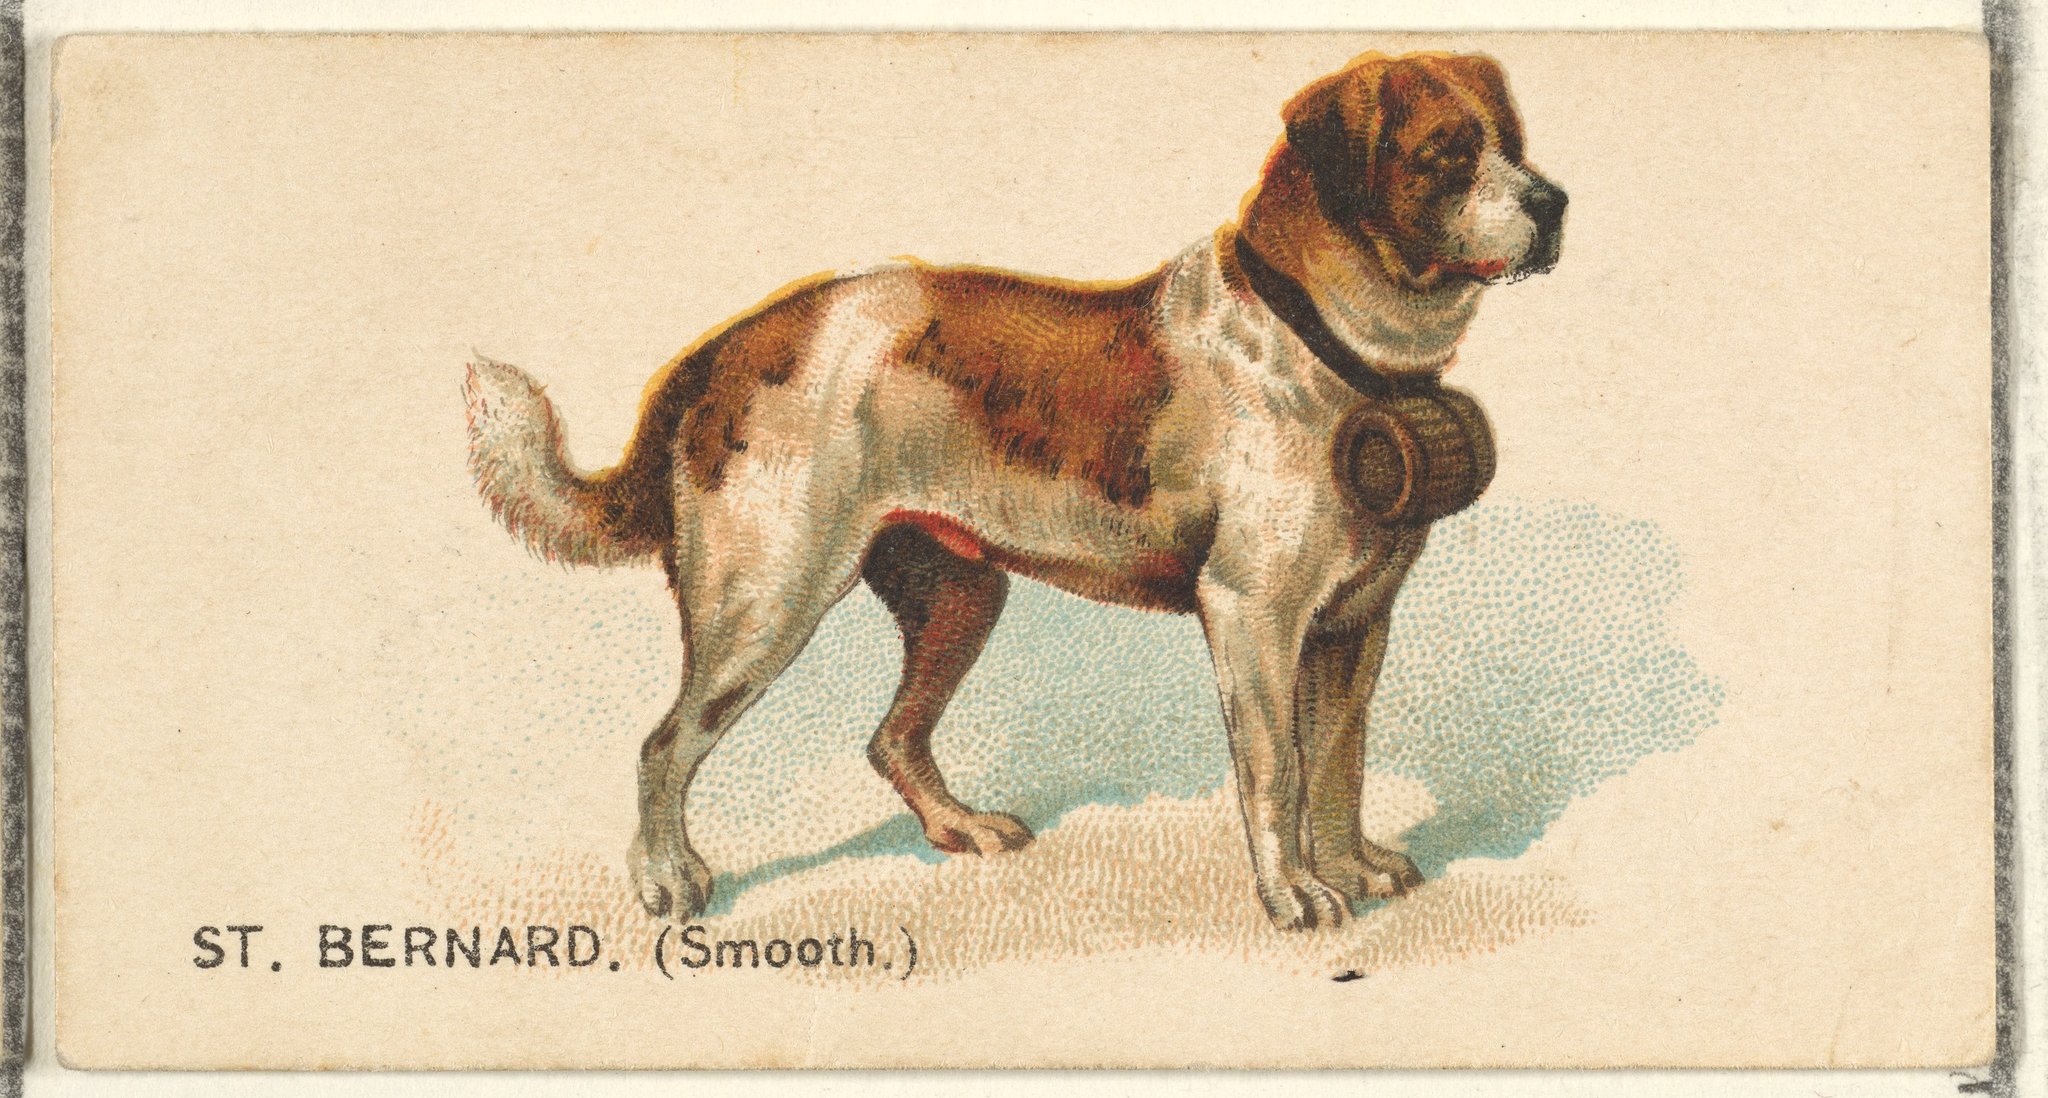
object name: print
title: St. Bernard (Smooth), from the Dogs of the World series for Old Judge Cigarettes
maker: goodwin & company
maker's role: publisher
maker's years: 1850-1950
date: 1890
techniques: color lithograph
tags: dogs